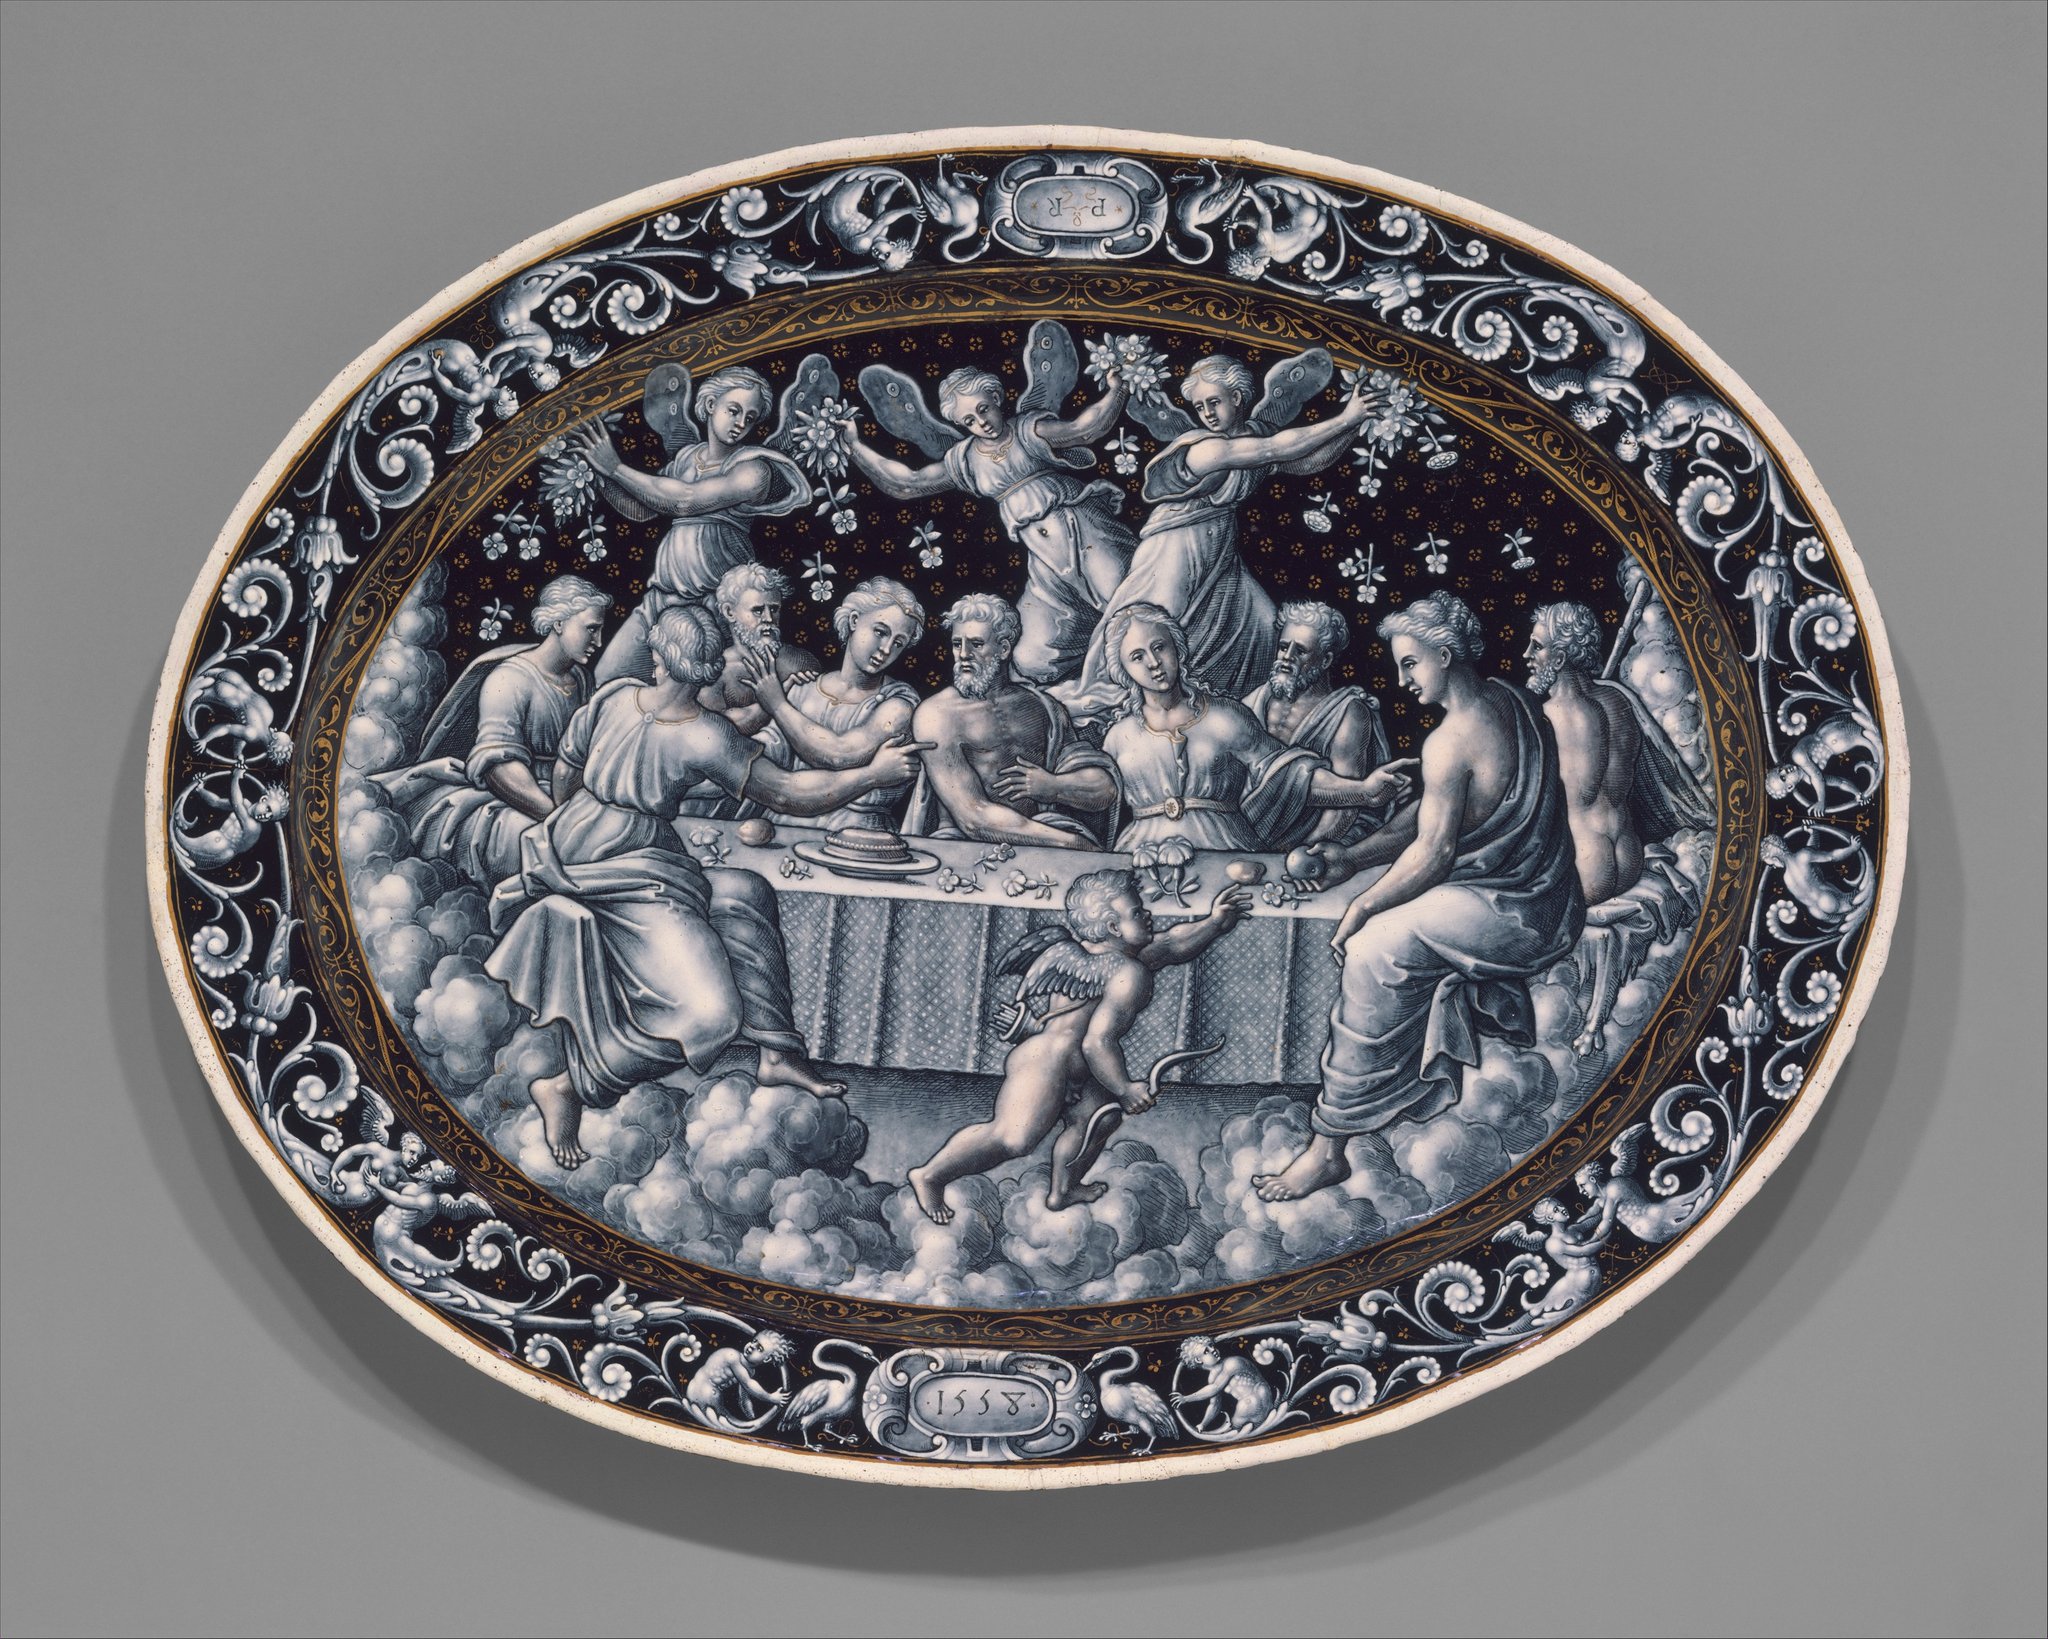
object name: dish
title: The Wedding Feast of Cupid and Psyche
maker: pierre reymond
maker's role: artist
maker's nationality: french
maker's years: 1513-1590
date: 1558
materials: copper, enamel, gilt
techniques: painting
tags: men,women,cupid,psyche,dining